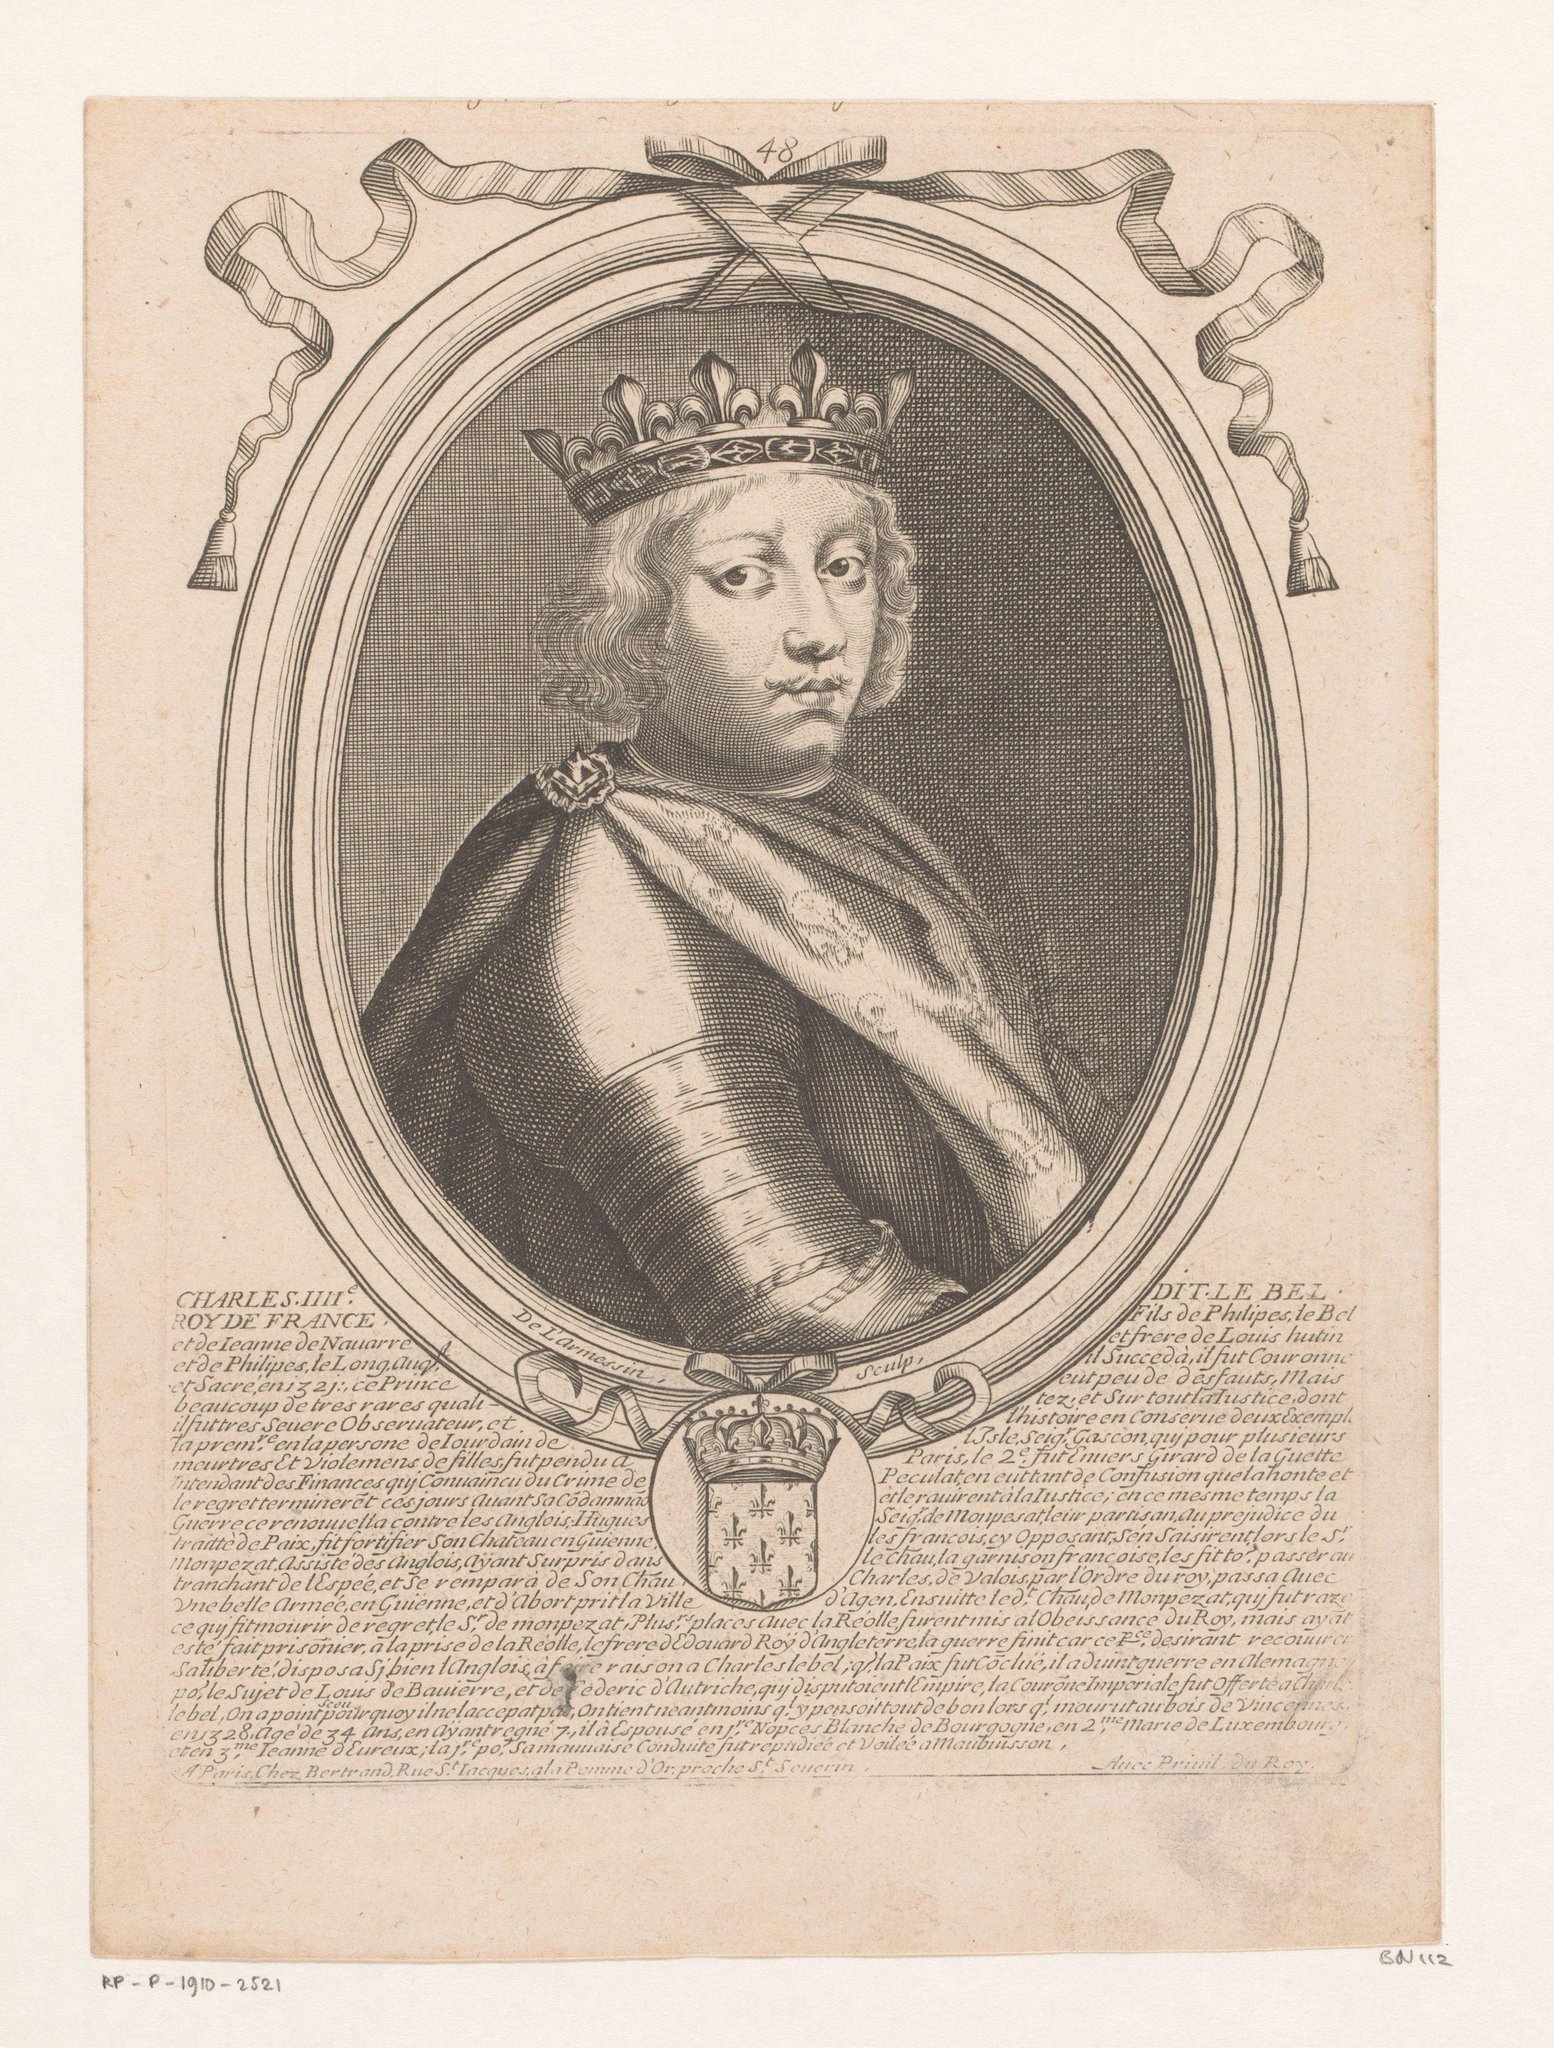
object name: print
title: Portretten van prominente figuren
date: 1642-1678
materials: paper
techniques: engraving, etching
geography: paris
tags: historical persons, king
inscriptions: collector's mark: Lugt 2228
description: Maakt deel uit van een grootschalige serie met portretten van prominente figuren. Binnen de serie bevindt zich een sectie getiteld 'Les Augustes Représentations De tous les Roys De France depuis Pharamond Iusqu'à Louys XIIII'. De serie werd respectievelijk uitgegeven door Pierre Bertrand, door zijn weduwe en door De Larmessin zelf.